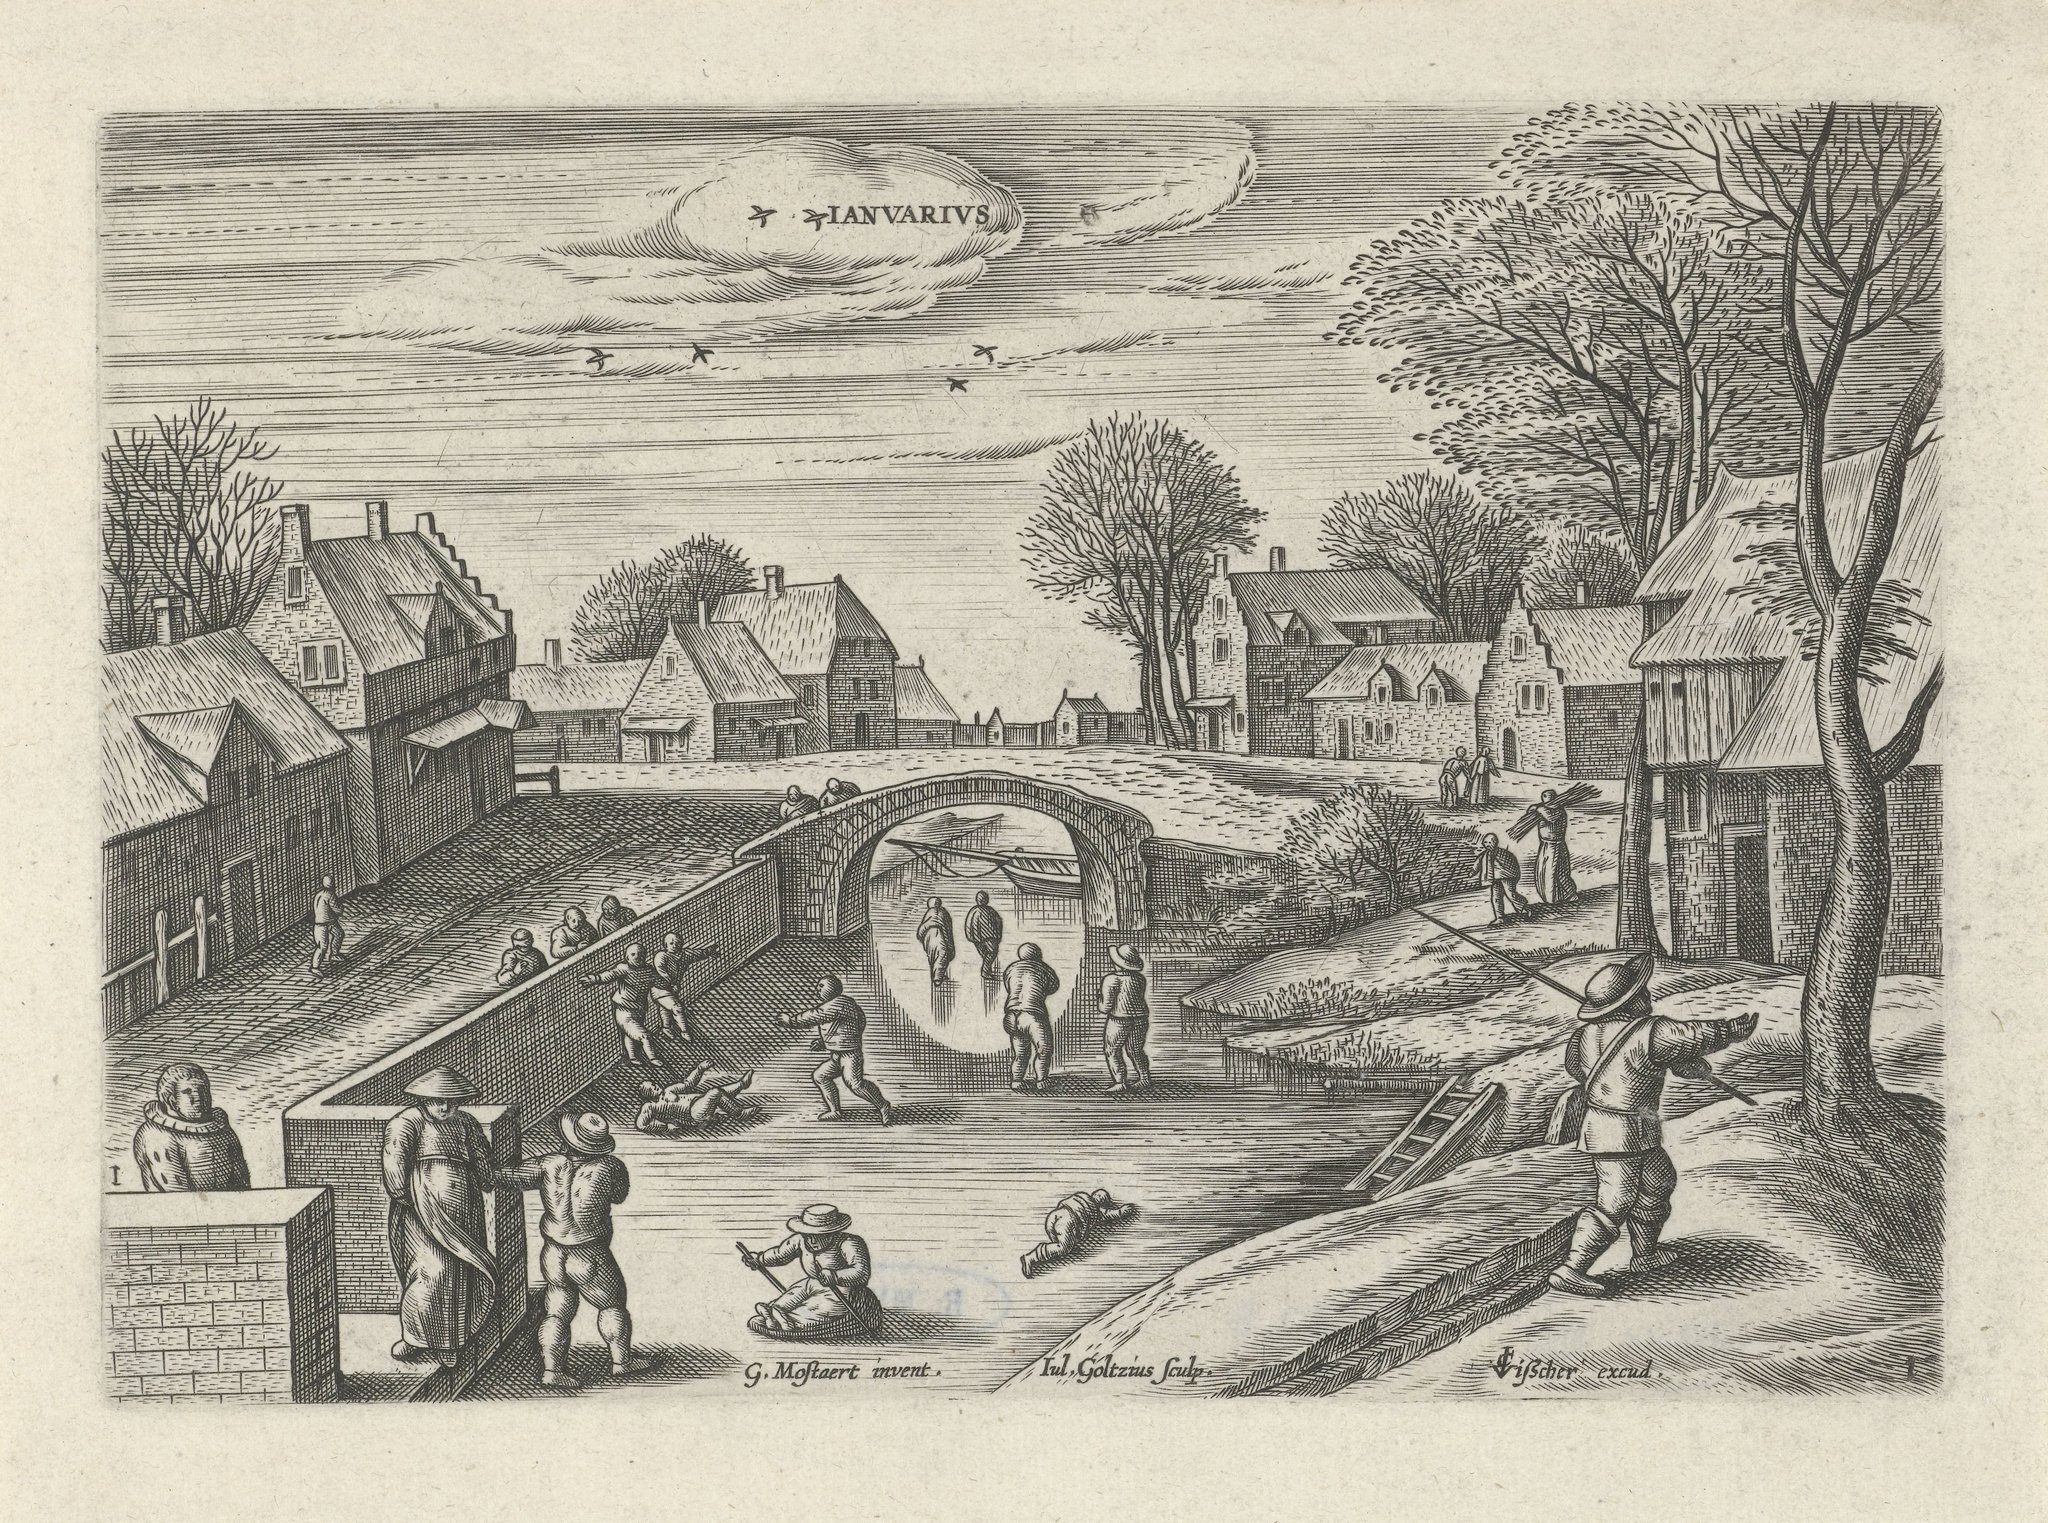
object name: print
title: Januari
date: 1596-1652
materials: paper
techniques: engraving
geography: antwerp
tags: january and its 'labours', skates (winter sports)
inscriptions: collector's mark: Lugt 2228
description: Winterlandschap met wintertaferelen. Januari is de ijsmaand. Er wordt geschaatst op een kanaal. Mensen zoeken naar sprokkelhout. Deel van een serie van de twaalf maanden, waarbij elke maand wordt afgebeeld met de voor haar typerende menselijke activiteiten en haar klimatologische kenmerken.